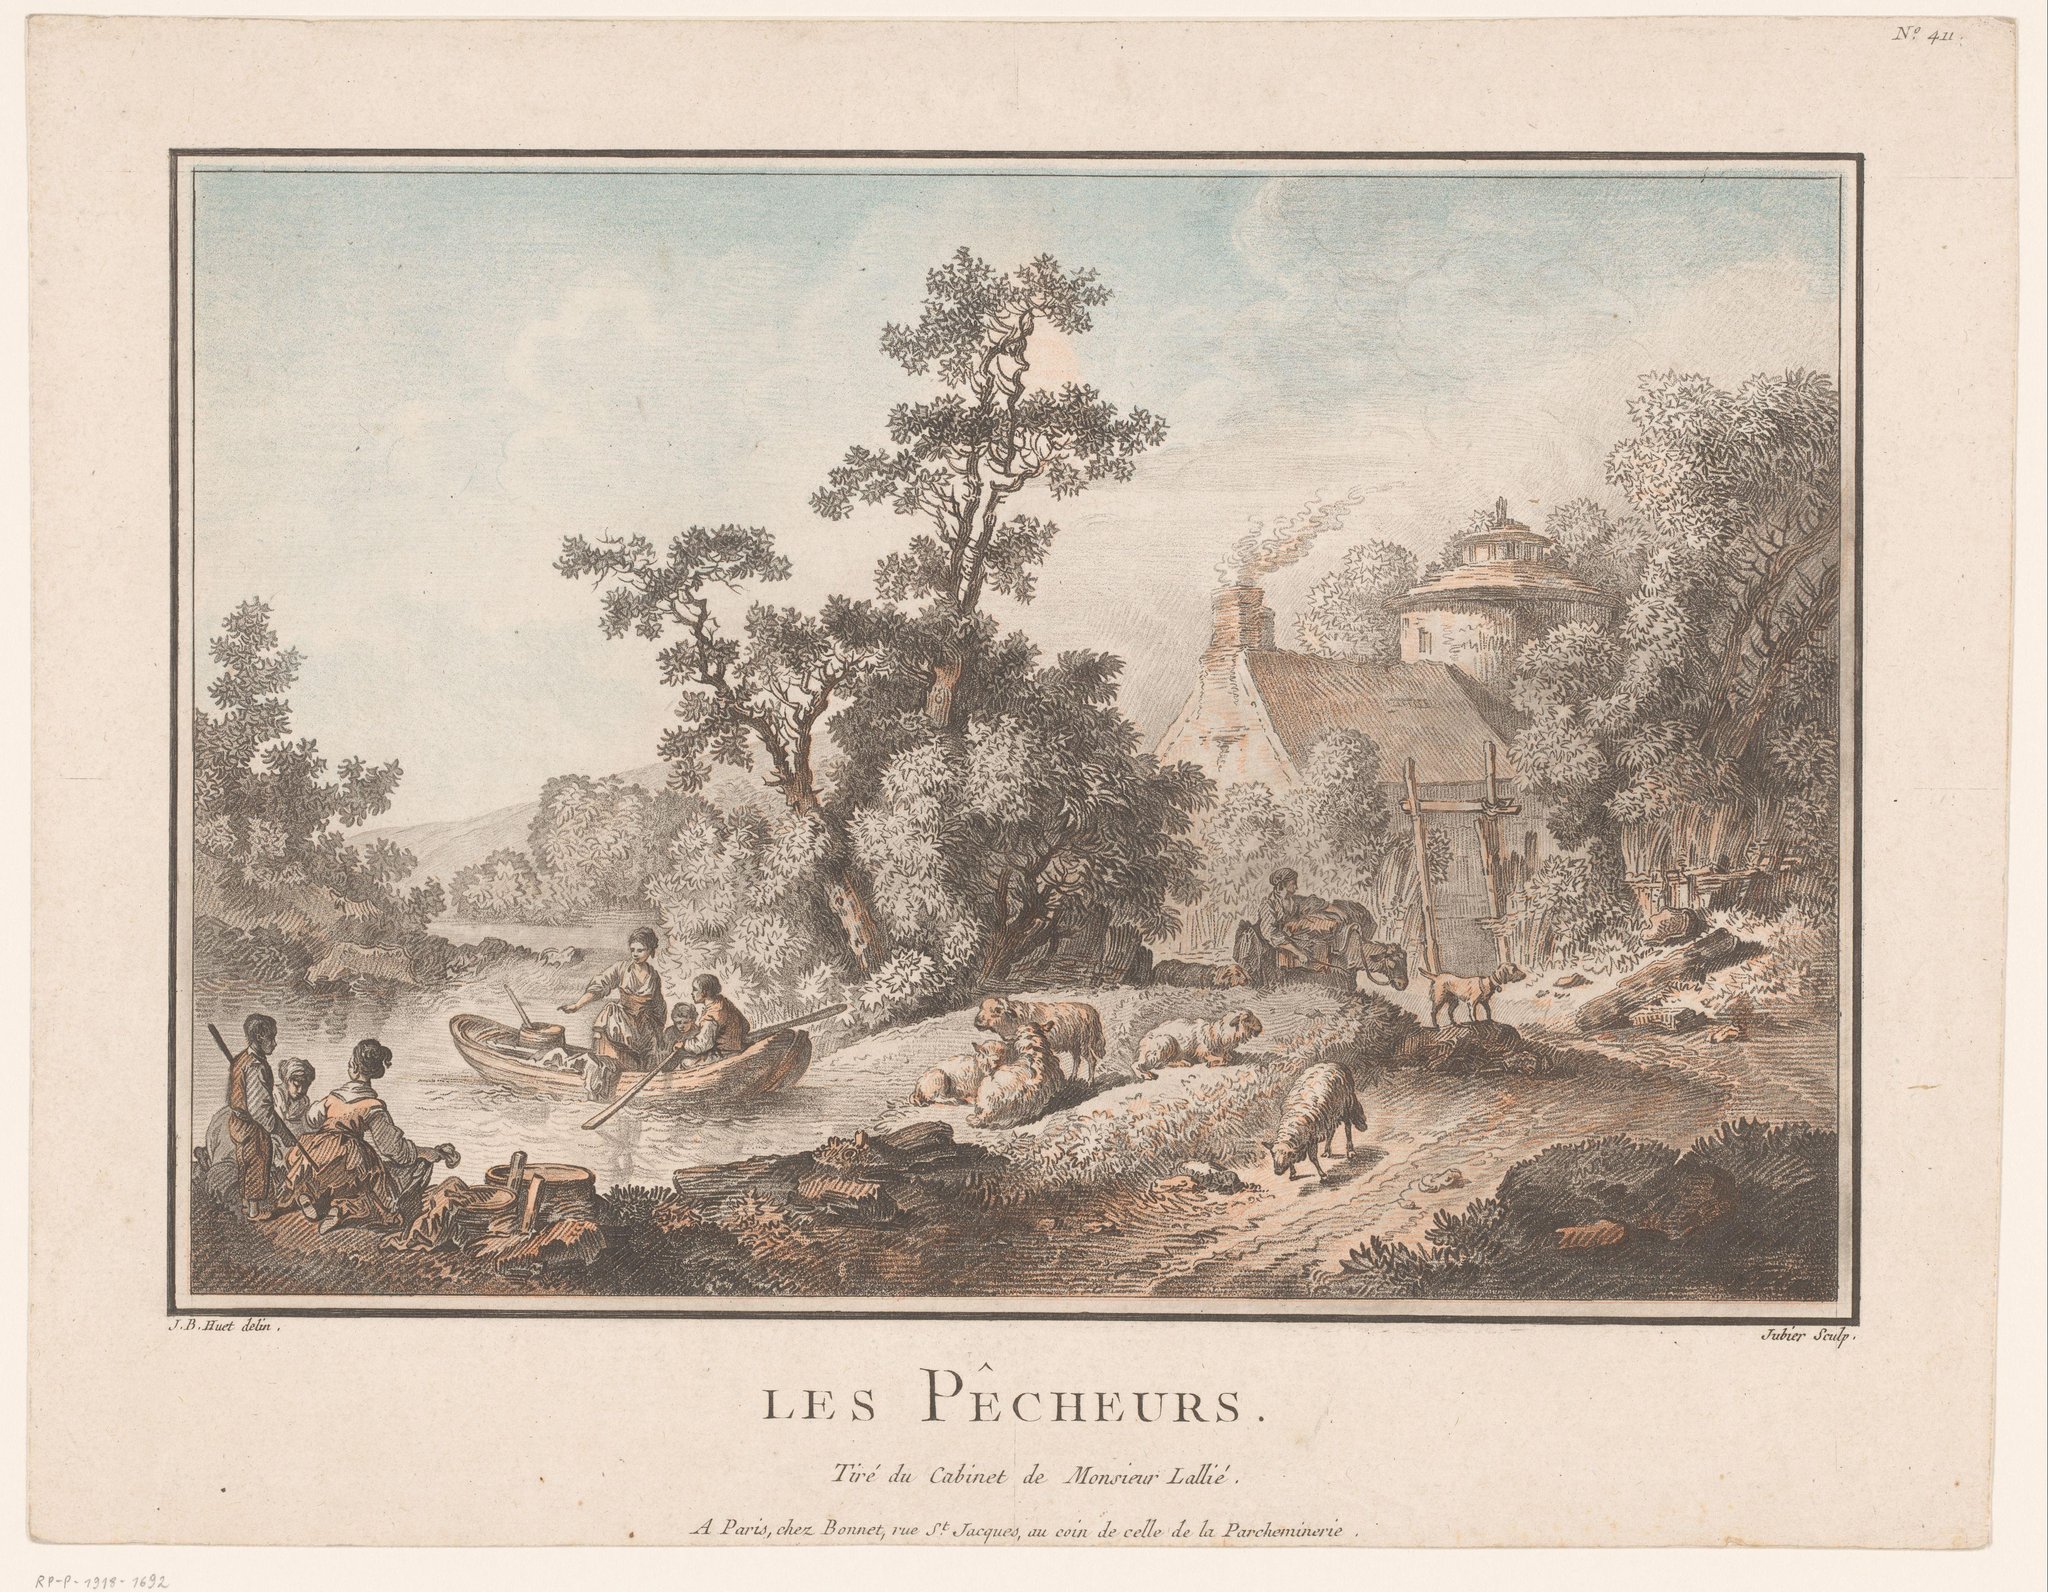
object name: print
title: Landschap met herders en vissers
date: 1755-1786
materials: paper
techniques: printmaking, etching, lithography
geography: france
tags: water course, herd, flock, fisherman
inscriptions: collector's mark: Lugt 2233